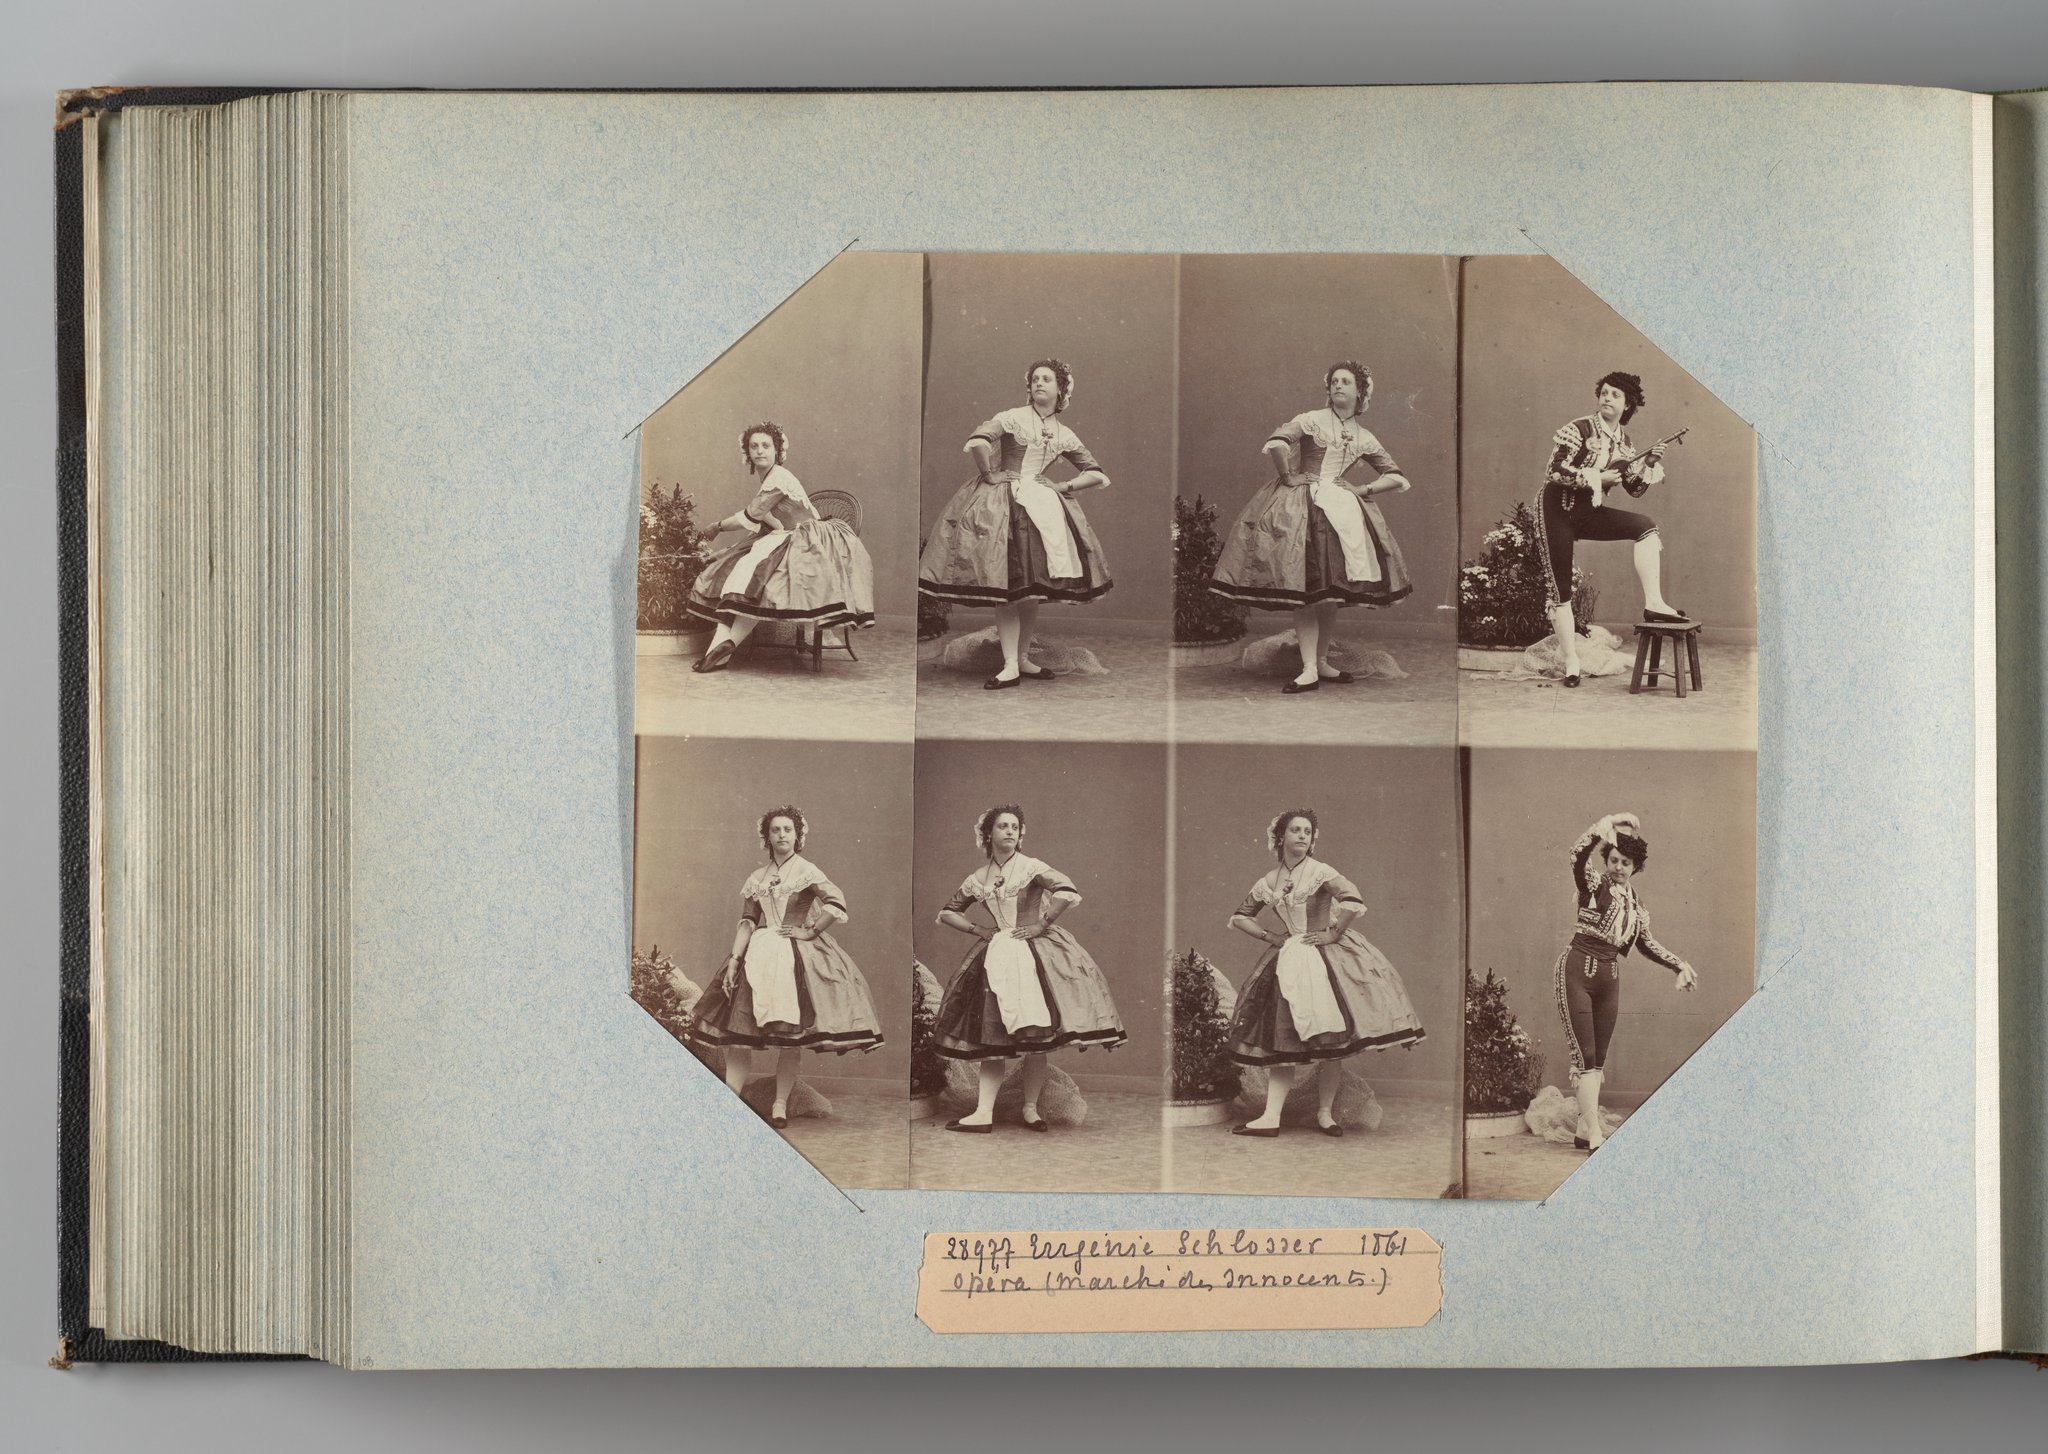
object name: photograph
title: Eugénie Schlosser dans la Marche des Innocents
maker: andré-adolphe-eugène disdéri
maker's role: artist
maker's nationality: french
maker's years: 1819-1889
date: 1861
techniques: albumen silver print, glass negative